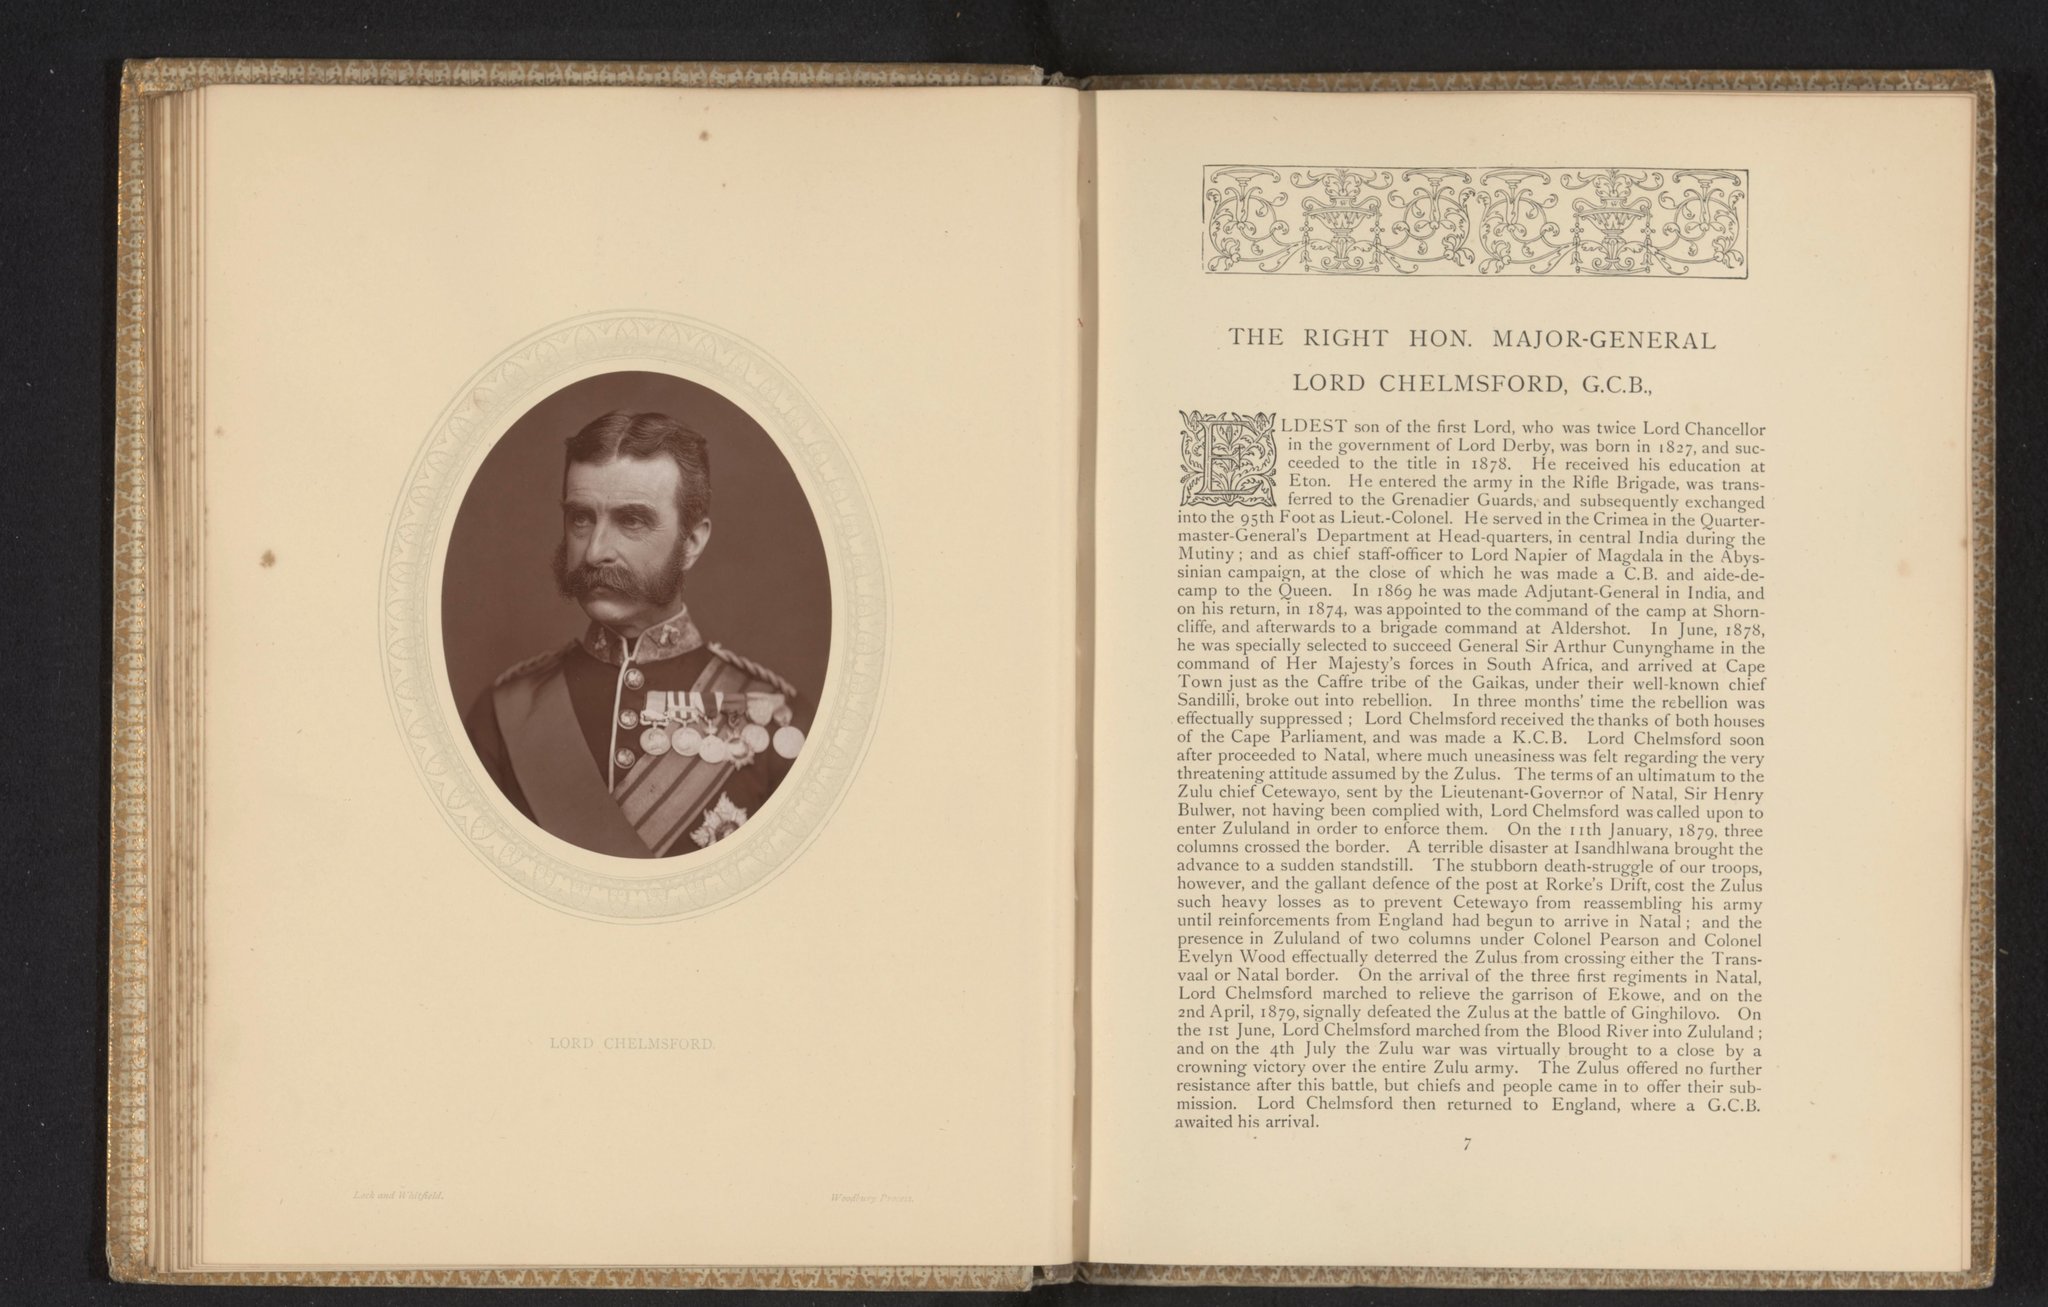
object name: photomechanical print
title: Lord Chelmsford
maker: Anonymous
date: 1877-1882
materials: paper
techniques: woodburytype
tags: historical persons (portraits and scenes from the life) (+ (full) bust portrait), officer